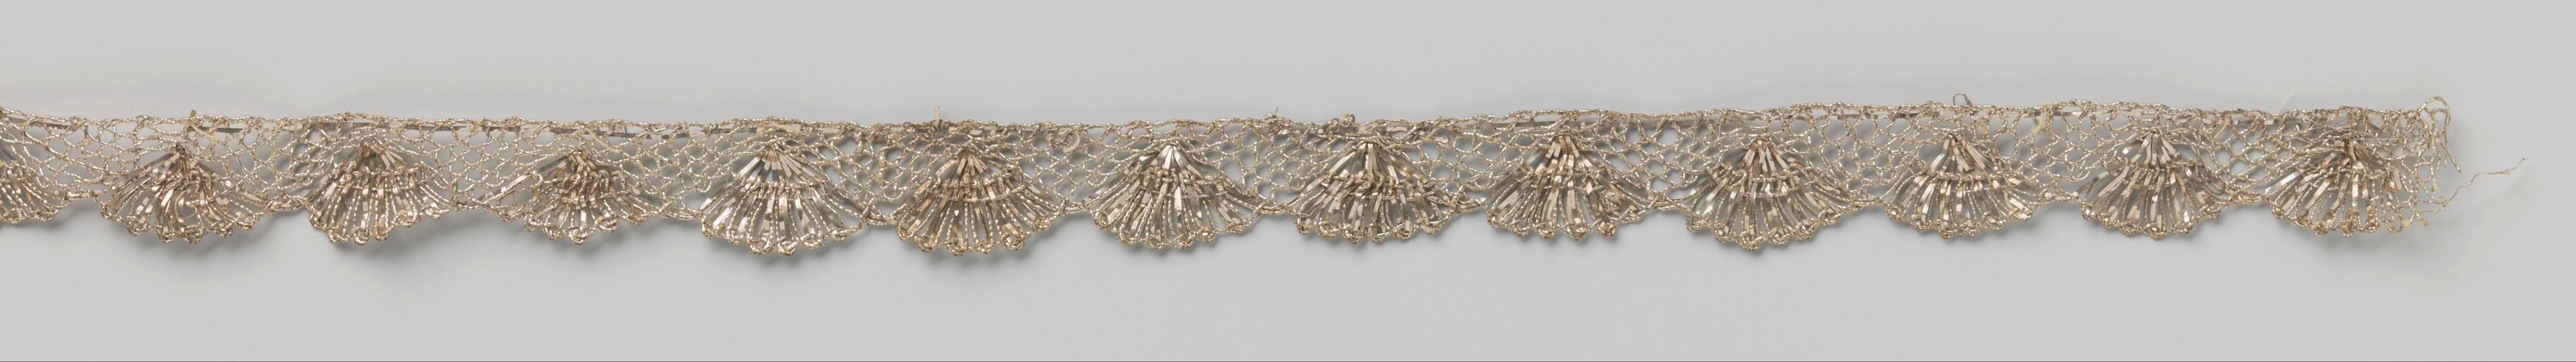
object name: strip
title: Strook zilverkant met waaiertjes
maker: Anonymous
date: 1700-1709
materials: thread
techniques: lace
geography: spain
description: Strook kloskant, zilverkant. Het zich herhalende patroon bestaat uit waaiertjes van zilverlameldraden en geribelde filédraden. De waaiertjes zijn met elkaar verbonden door een maasgrond, een vetergatslag-traliegrond. De bovenzijde is recht afgewerkt. De schulpen langs de onderzijde worden gevormd door de waaiertjes.